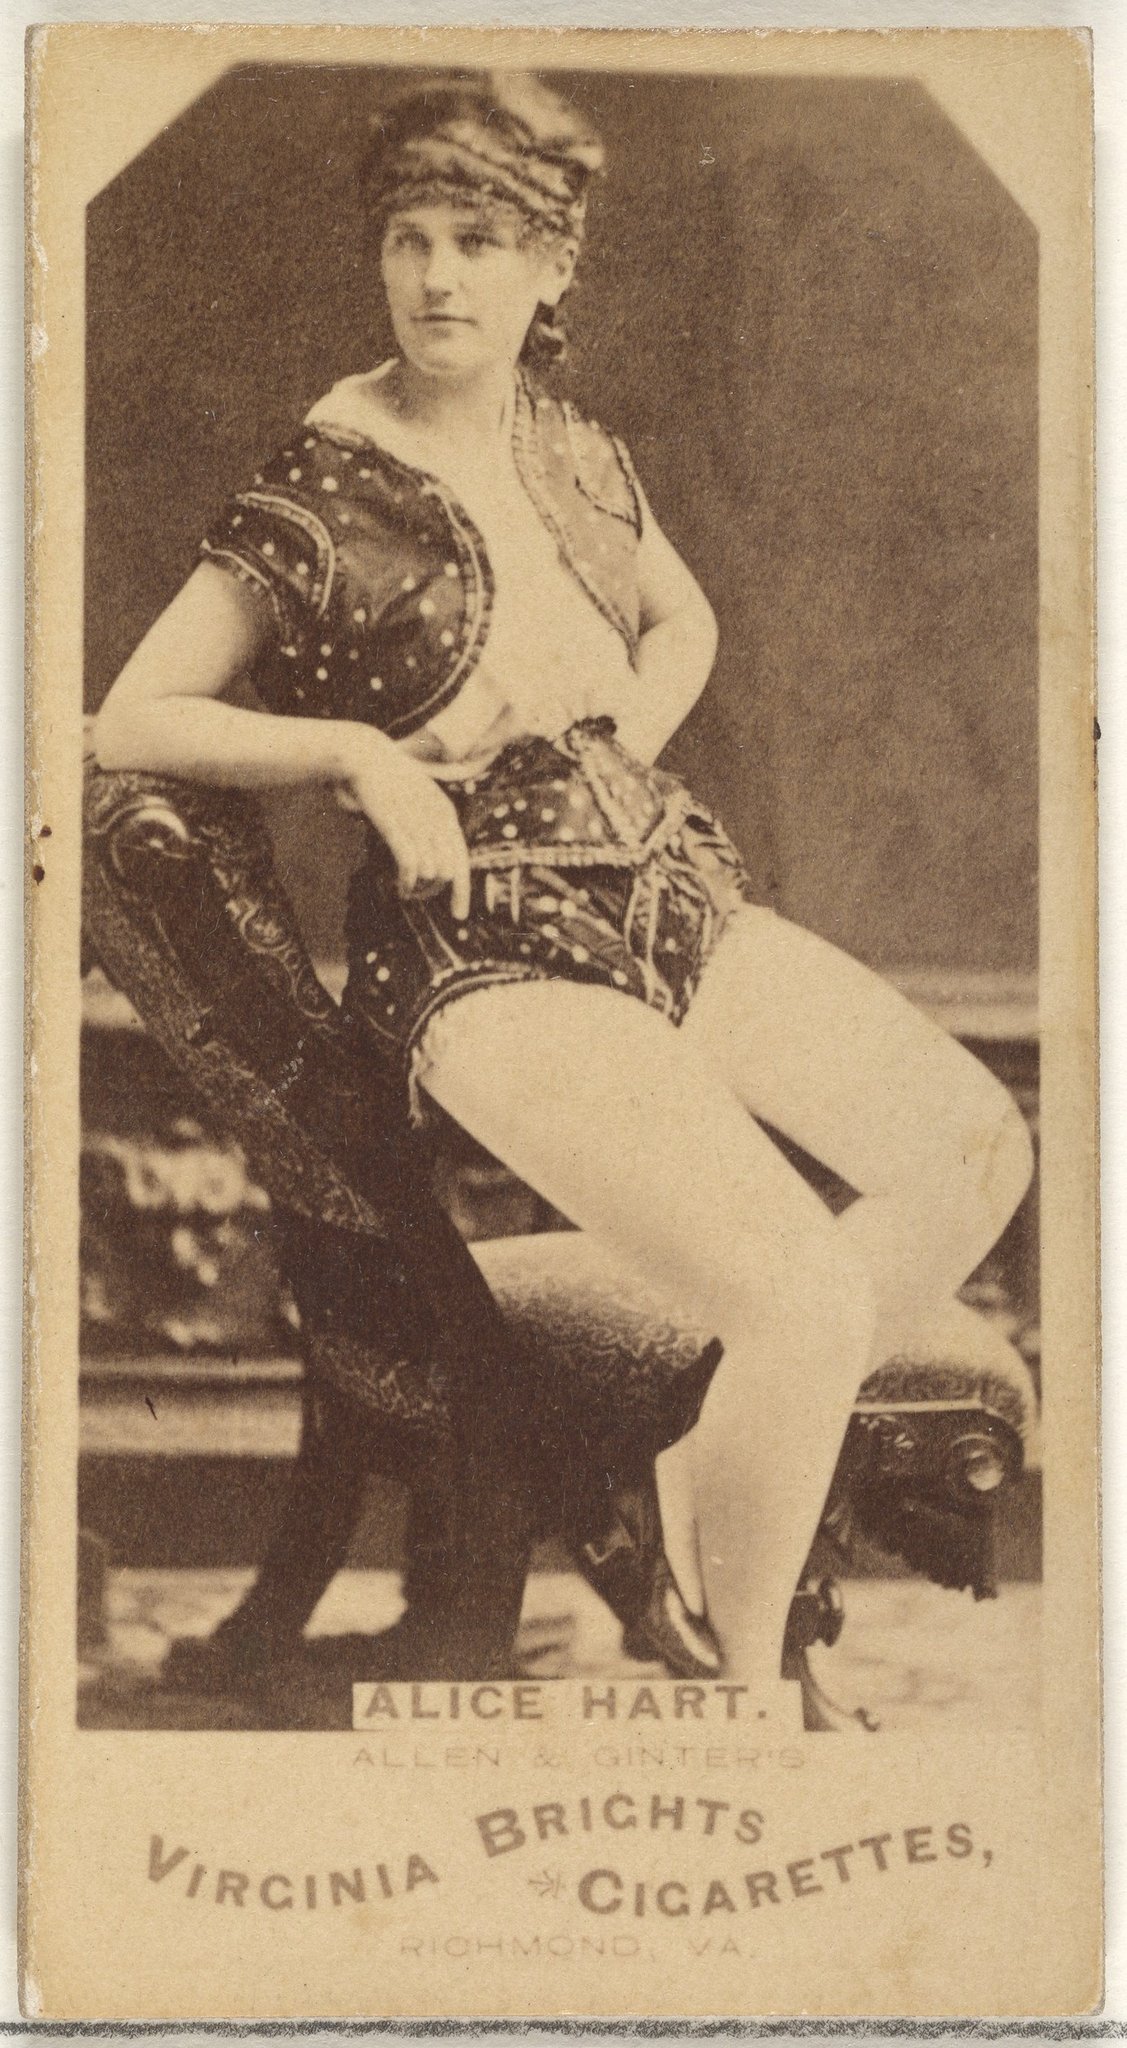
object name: photograph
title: Alice Hart, from the Actors and Actresses series (N45, Type 1) for Virginia Brights Cigarettes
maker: allen & ginter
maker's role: publisher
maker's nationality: american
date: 1888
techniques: albumen silver print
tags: portraits,women,actresses